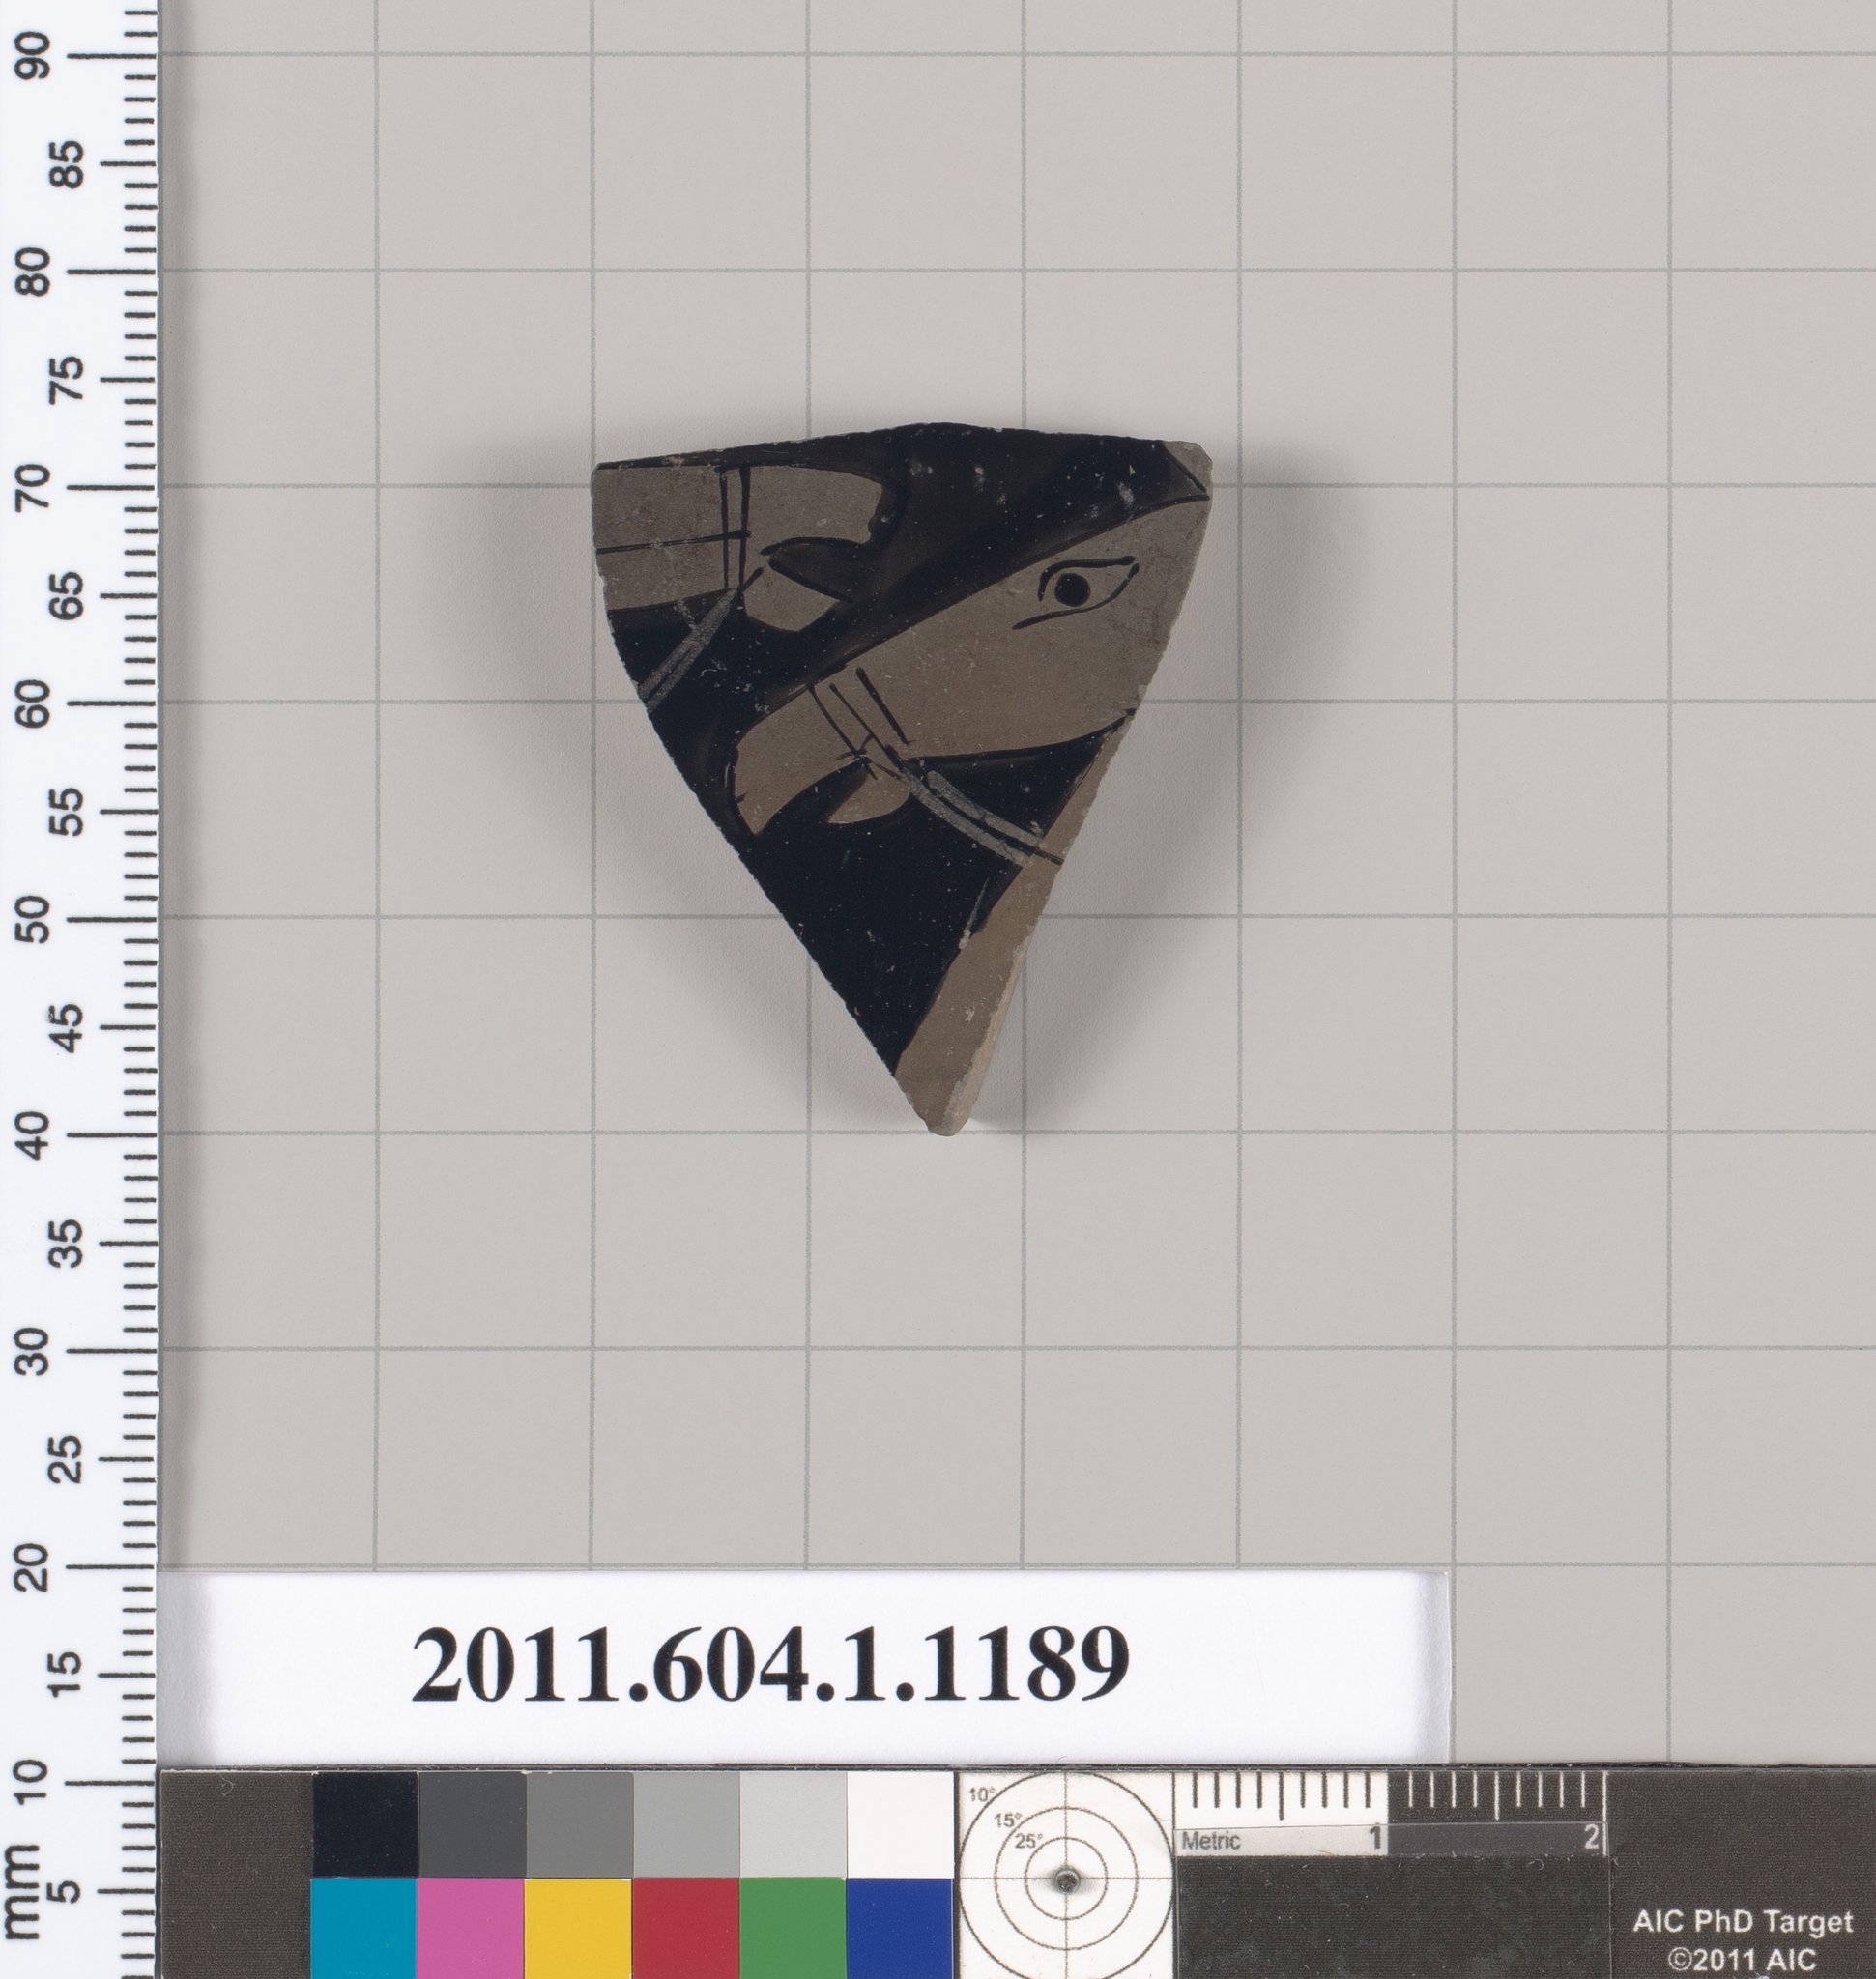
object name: kylix fragment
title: Terracotta fragment of a kylix (drinking cup)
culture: greek, attic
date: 490-480 BCE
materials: terracotta